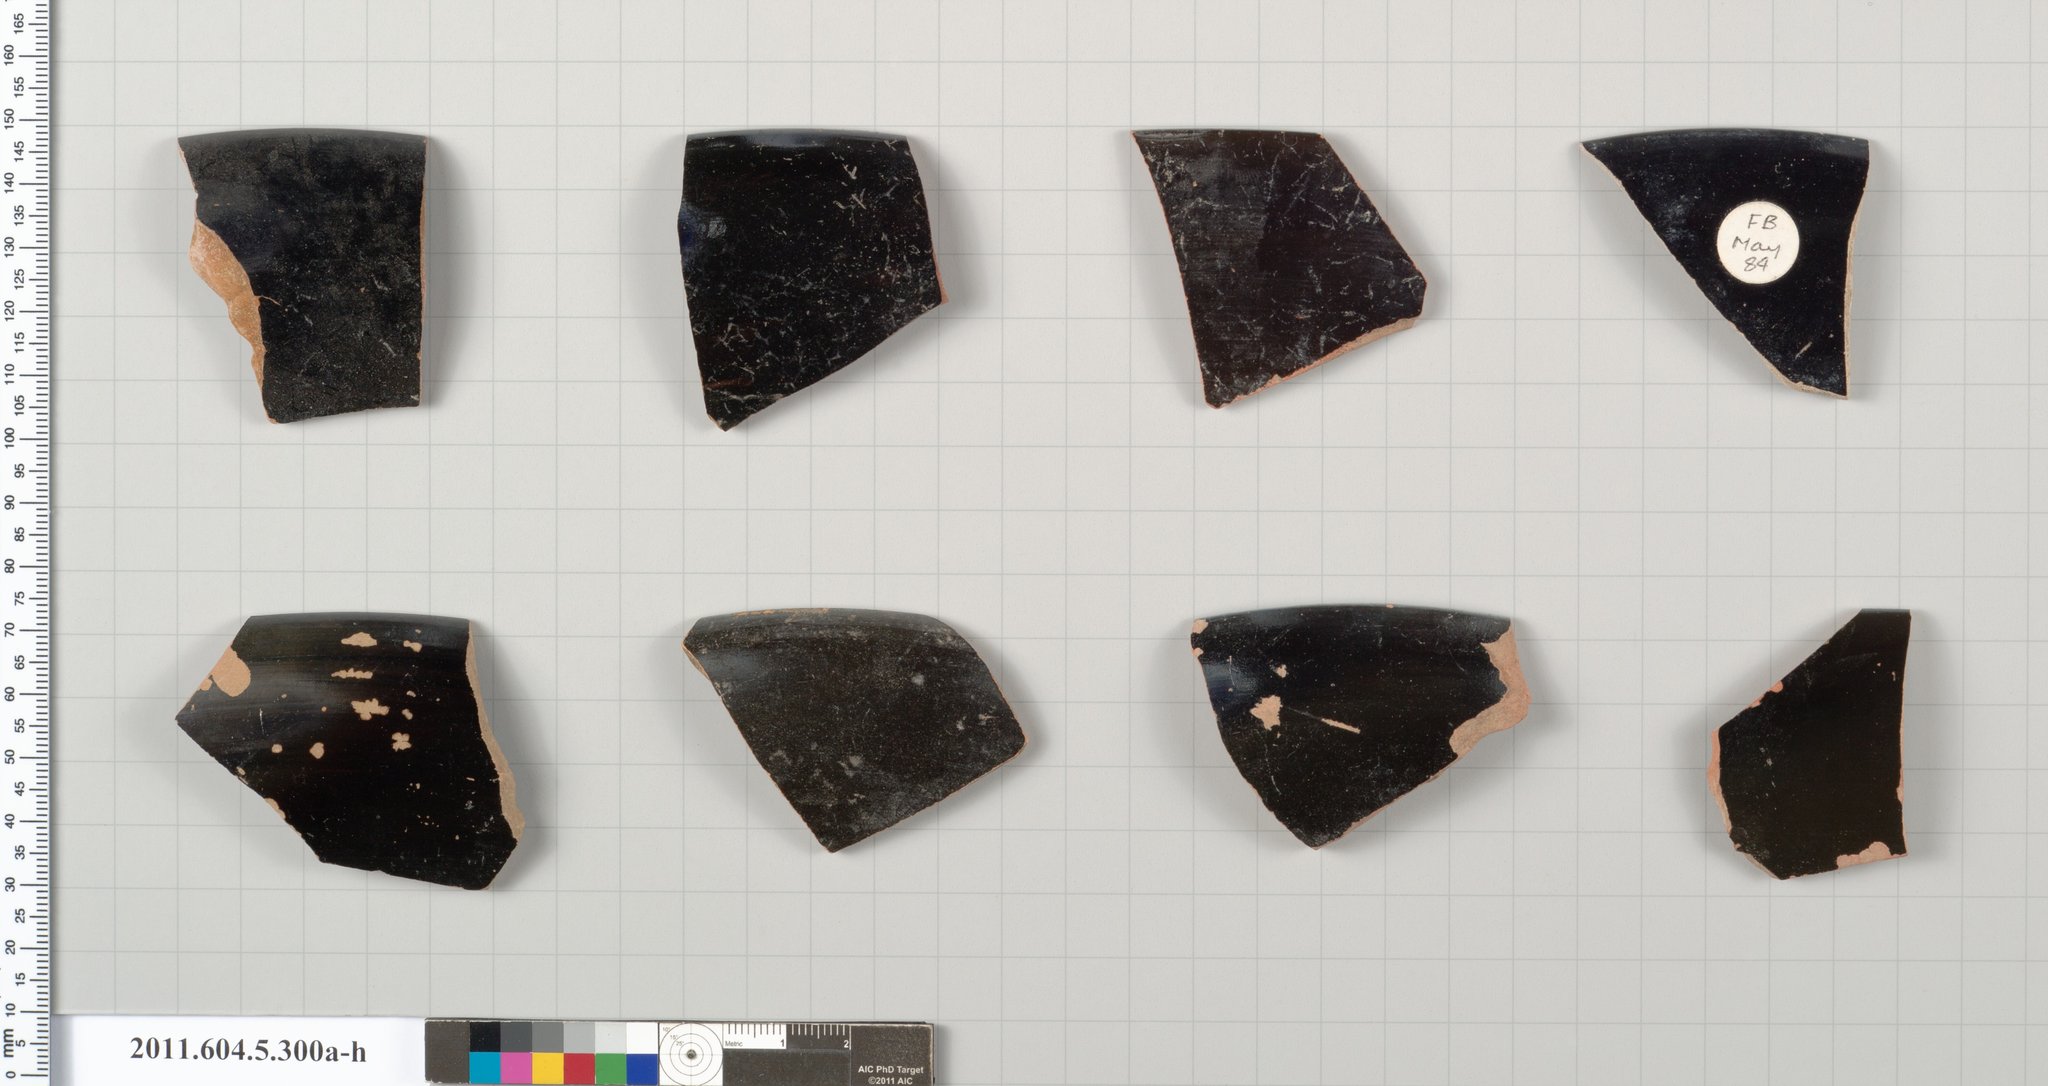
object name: kylix fragment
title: Terracotta rim fragments of kylikes (drinking cups)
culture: greek, attic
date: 600-401 BCE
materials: terracotta